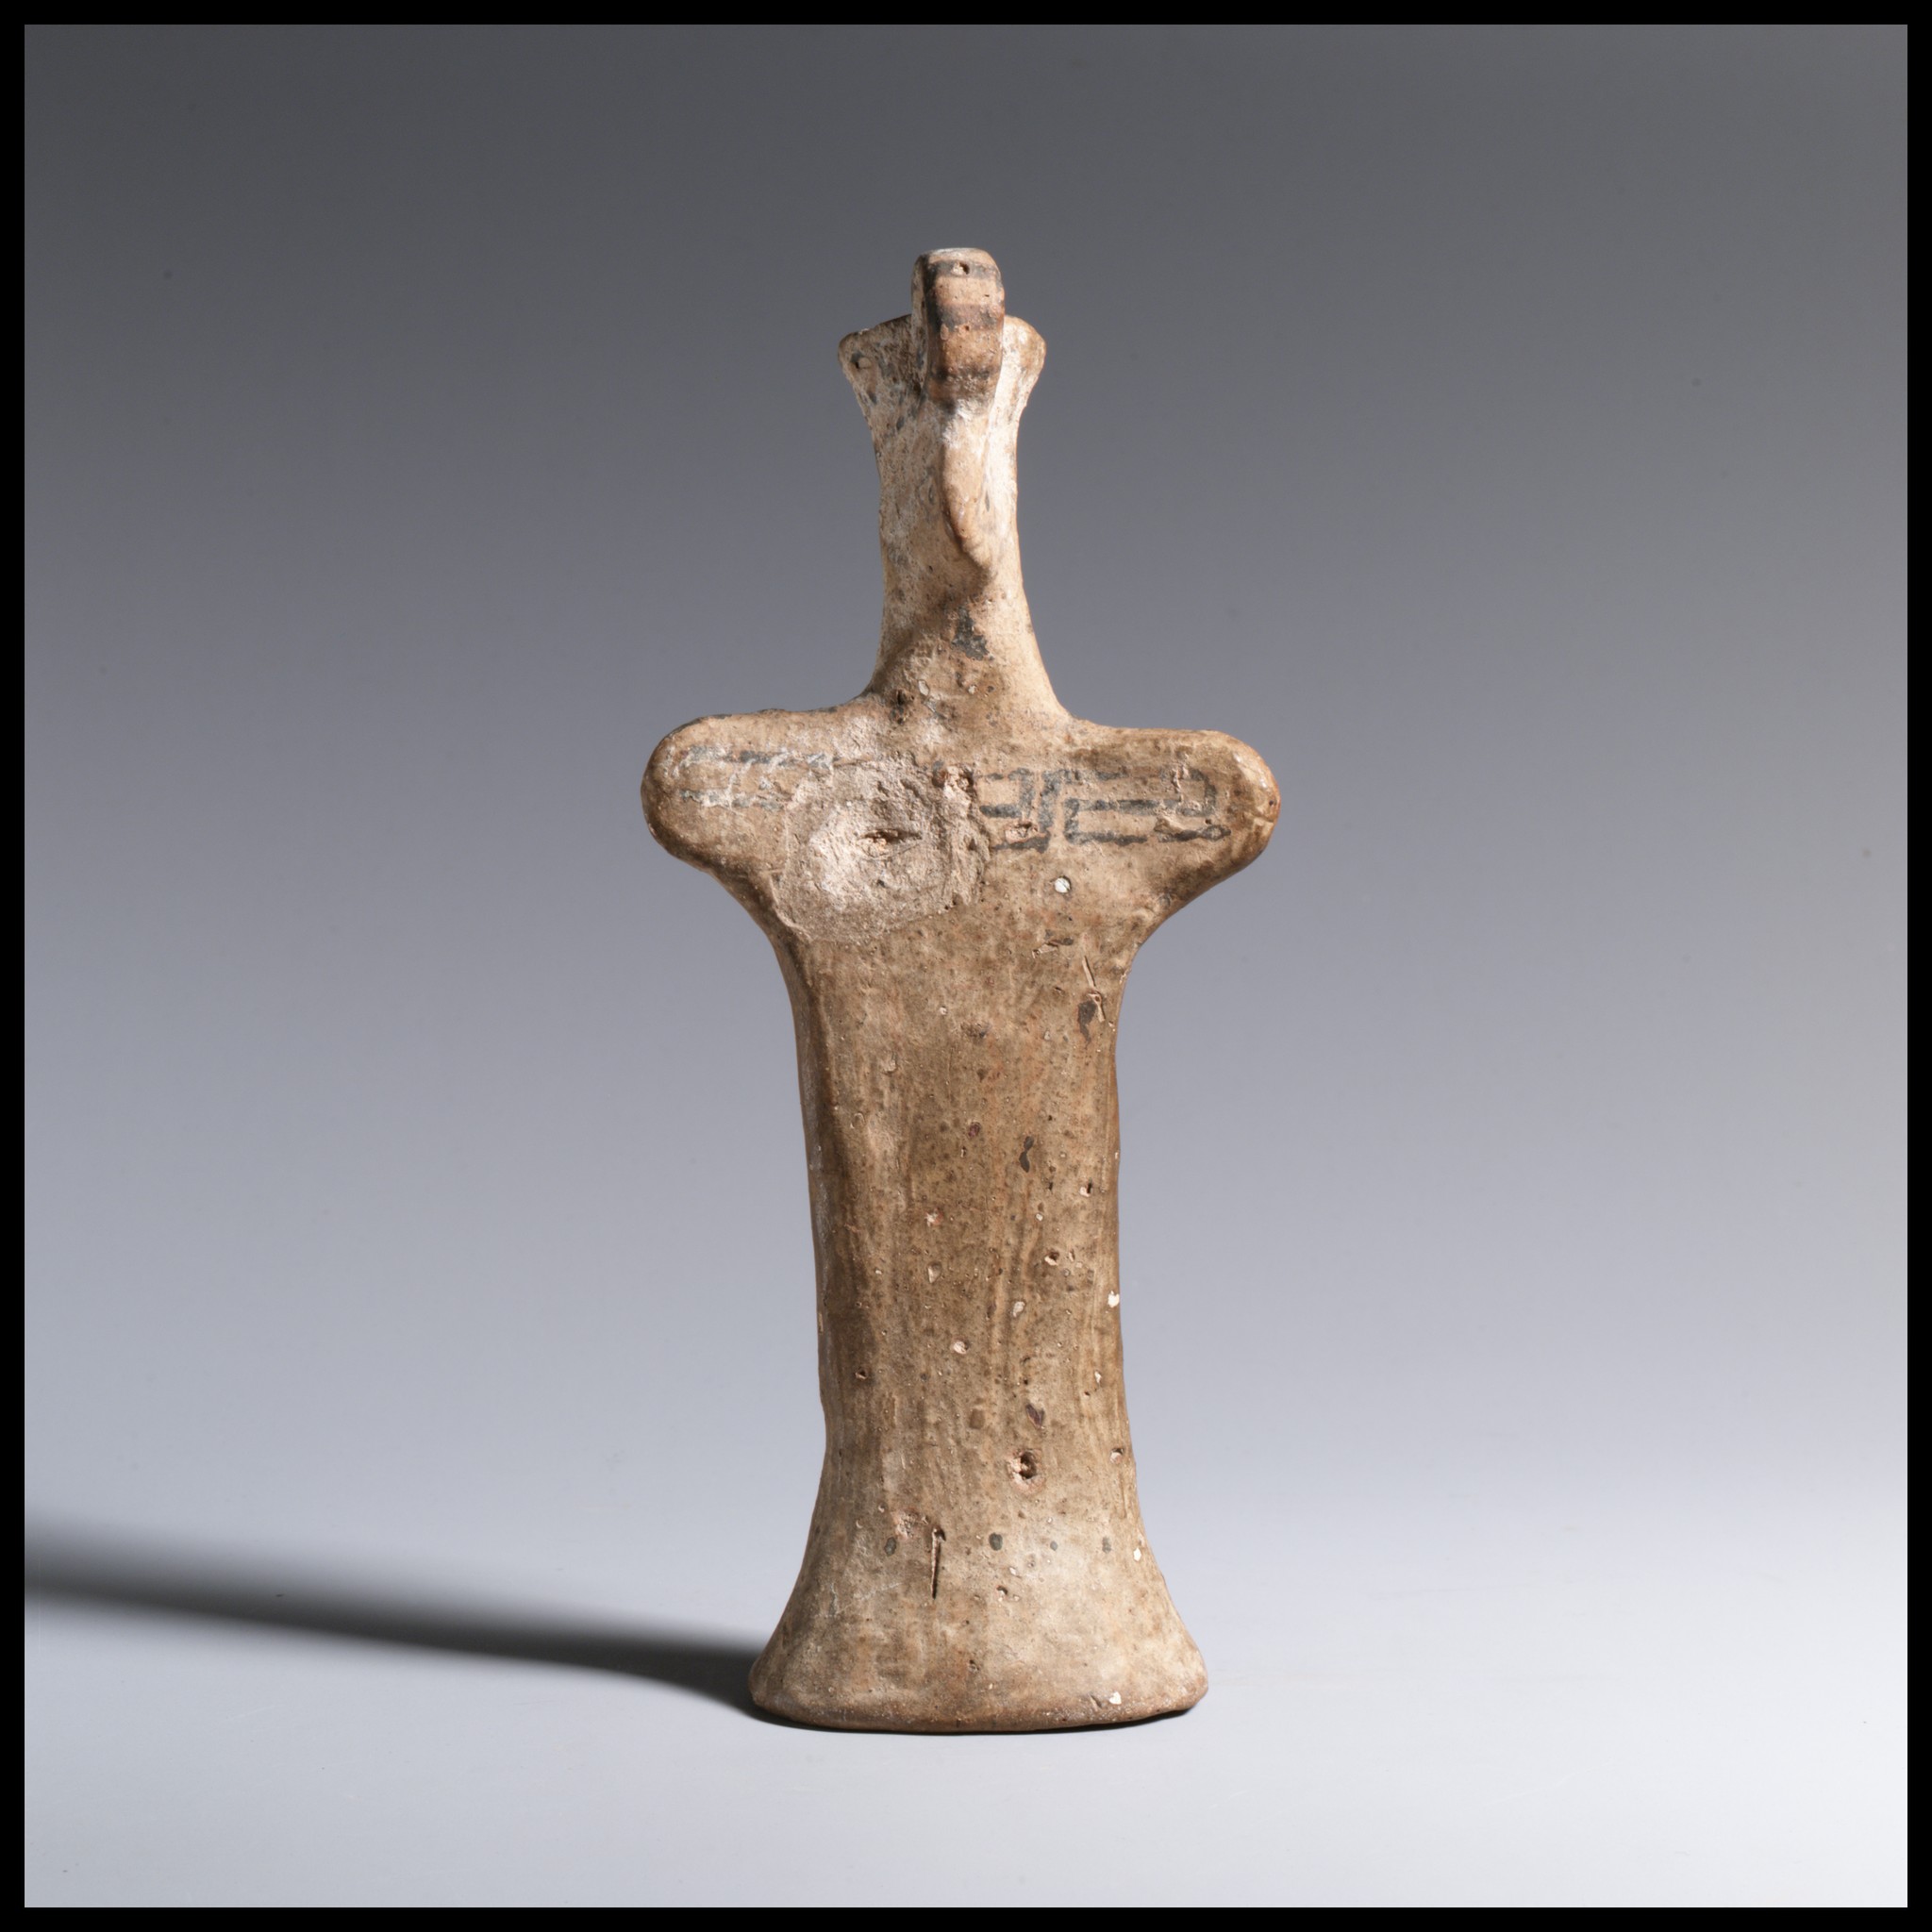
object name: statuette of a seated goddess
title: Terracotta statuette of a goddess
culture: greek, boeotian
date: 600-568 BCE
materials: terracotta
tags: goddess